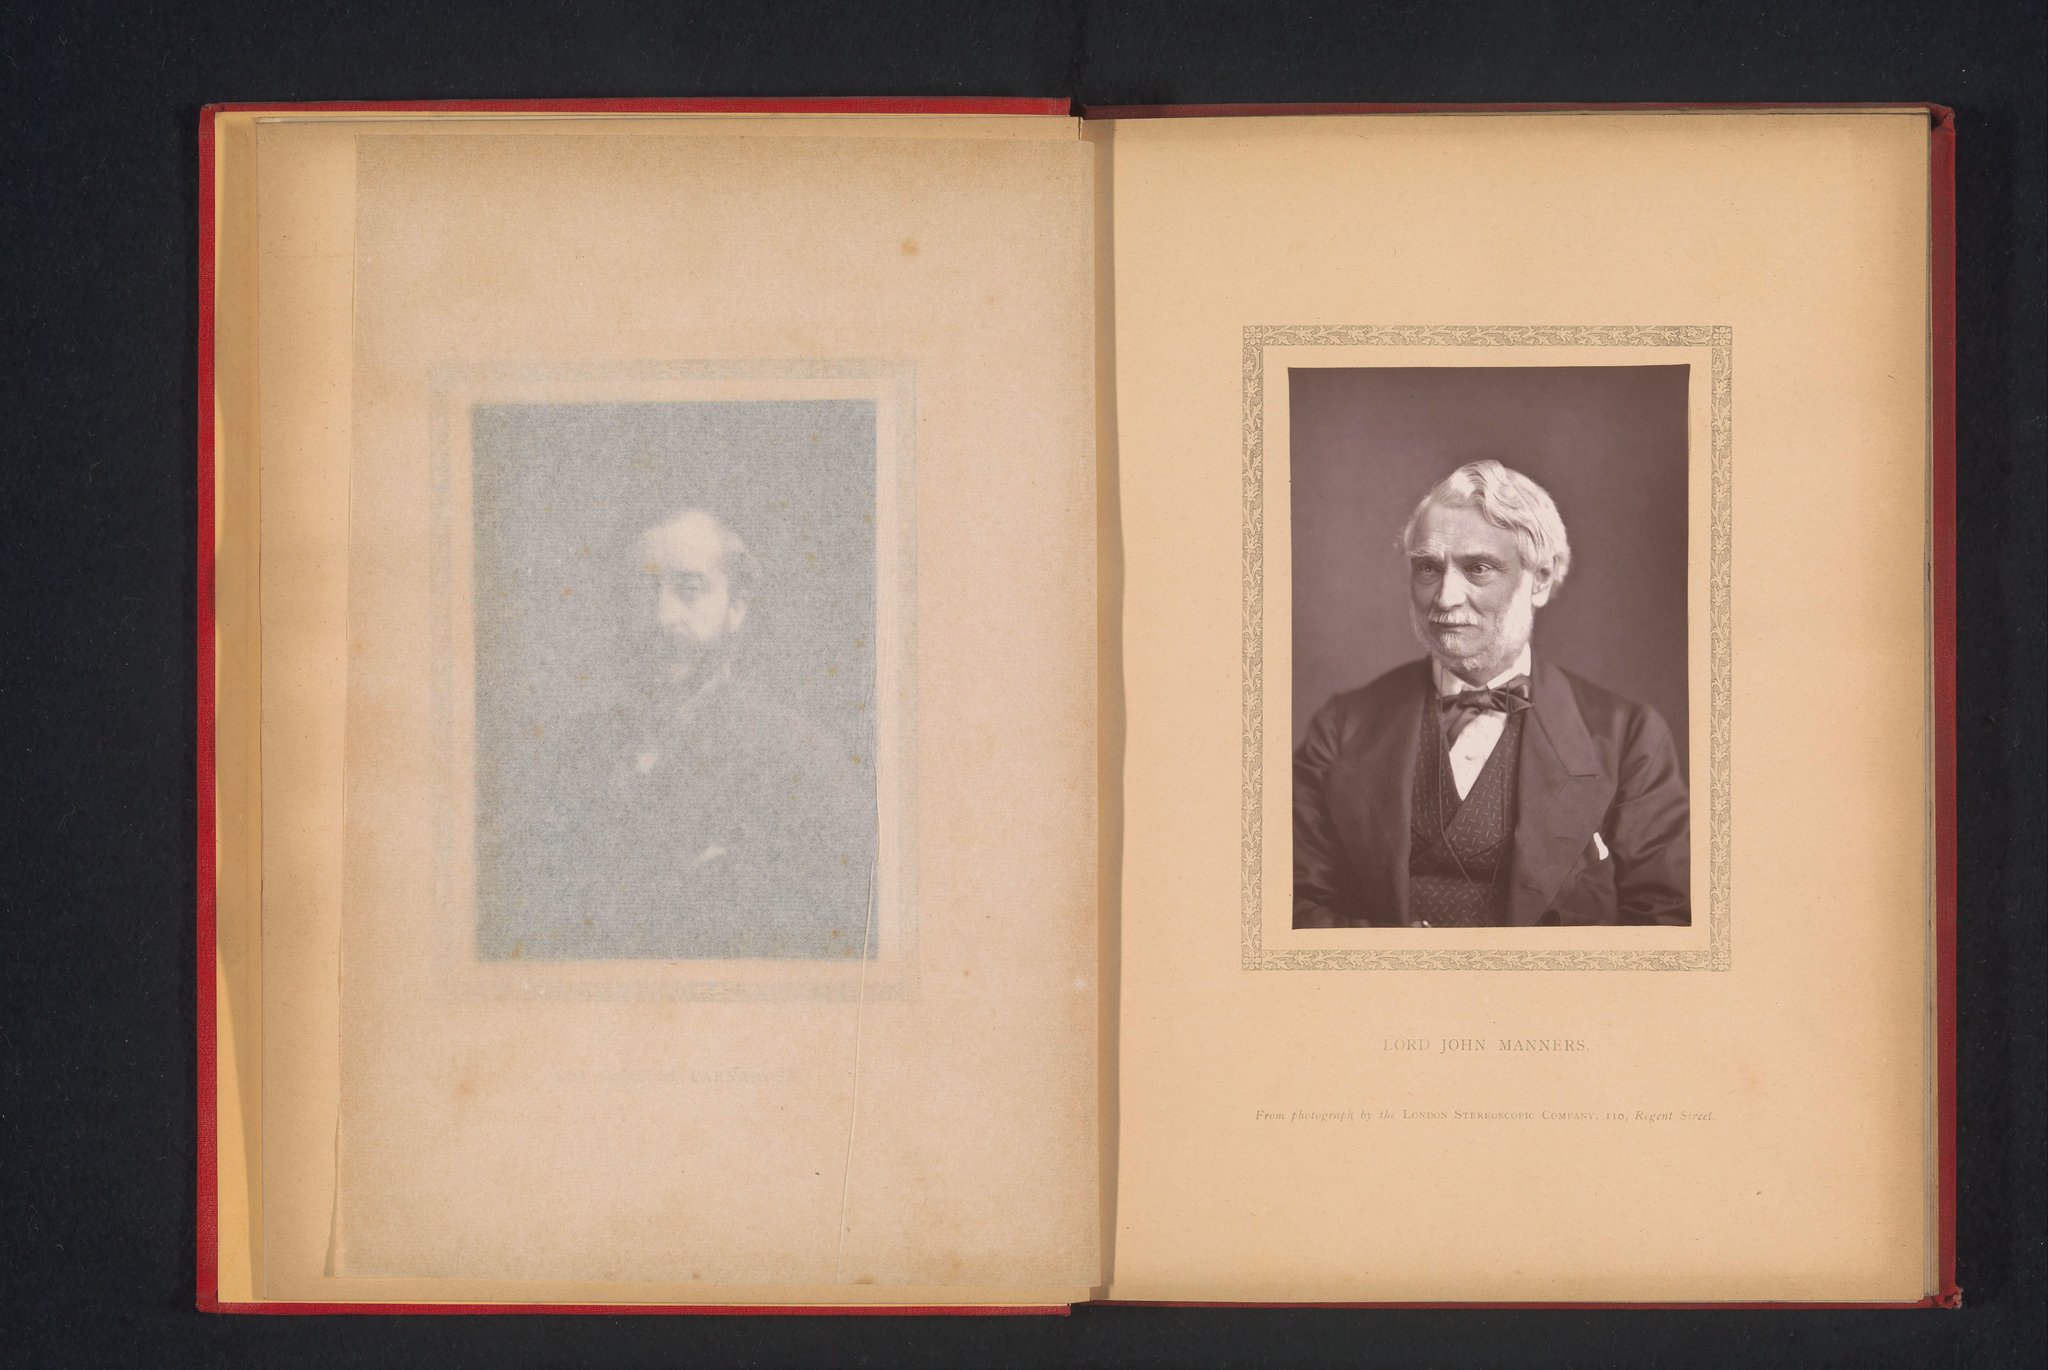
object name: photomechanical print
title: Lord John Manners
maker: Anonymous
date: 1871-1881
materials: paper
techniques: woodburytype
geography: london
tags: politician, e.g. party leader